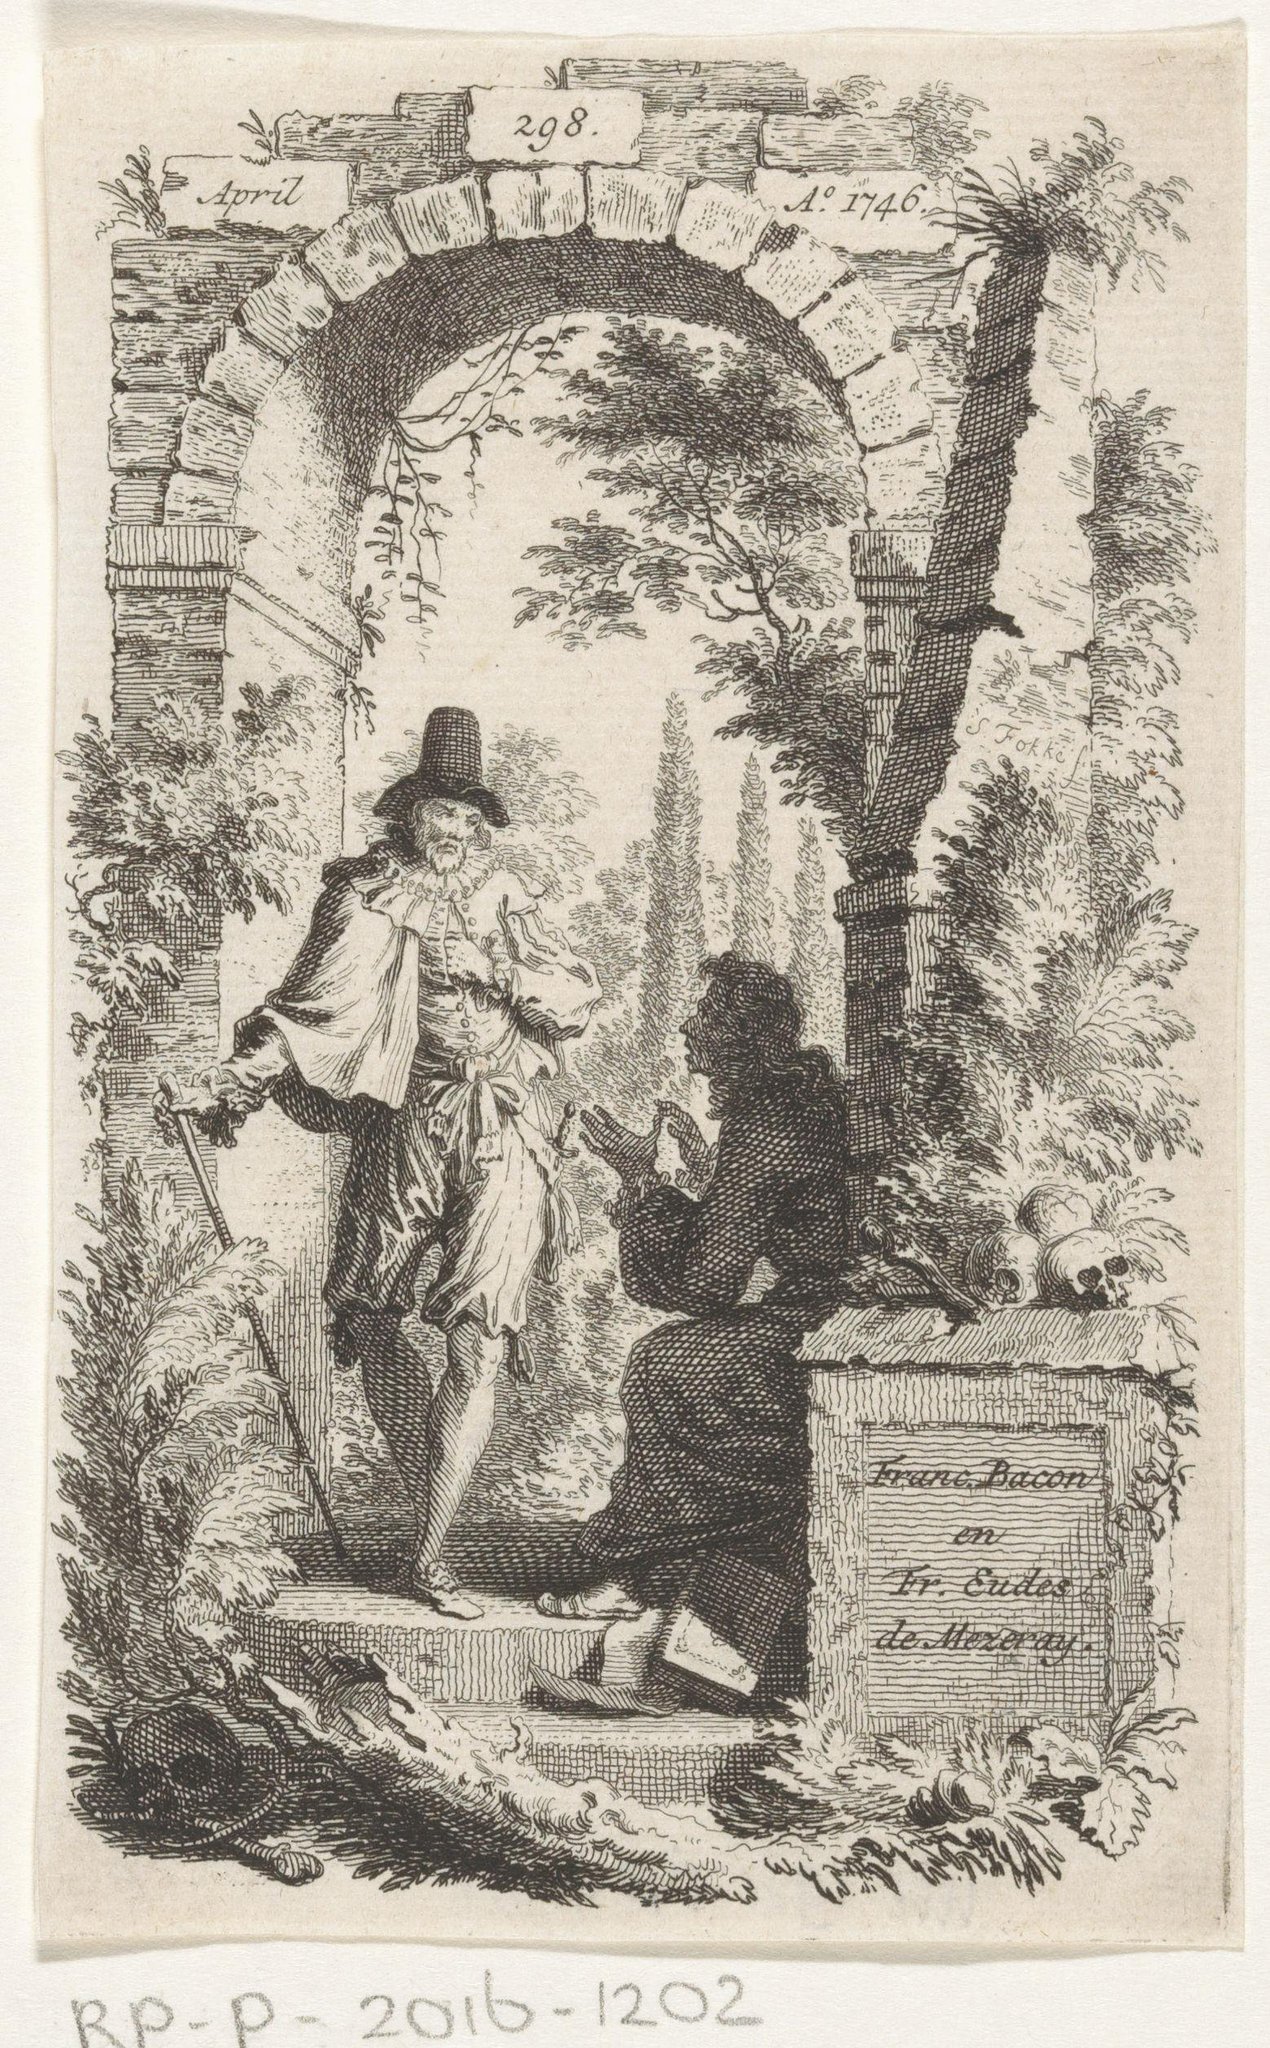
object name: book illustration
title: Franc. Bacon en Fr. Eudes de Mezeray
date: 1704-1746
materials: paper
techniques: etching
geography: amsterdam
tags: london, conversation, dialogue; conversation piece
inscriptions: collector's mark: Lugt 2228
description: Wetenschapper Francis Bacon met stok staat onder een rondboog naast componist François Eudes de Mézeray. Aan de bovenzijde vermeld: April / Ao 1746.